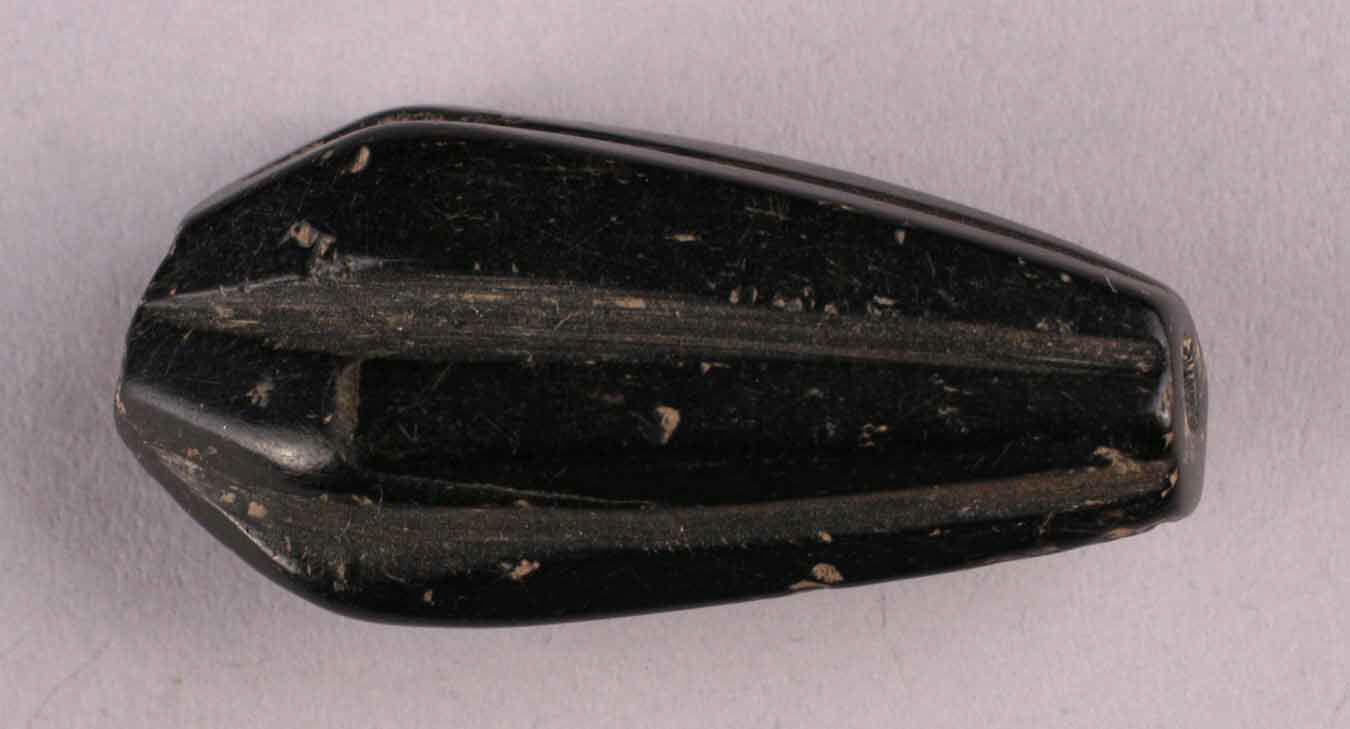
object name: bead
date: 701-1300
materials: stone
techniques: cutting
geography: iran